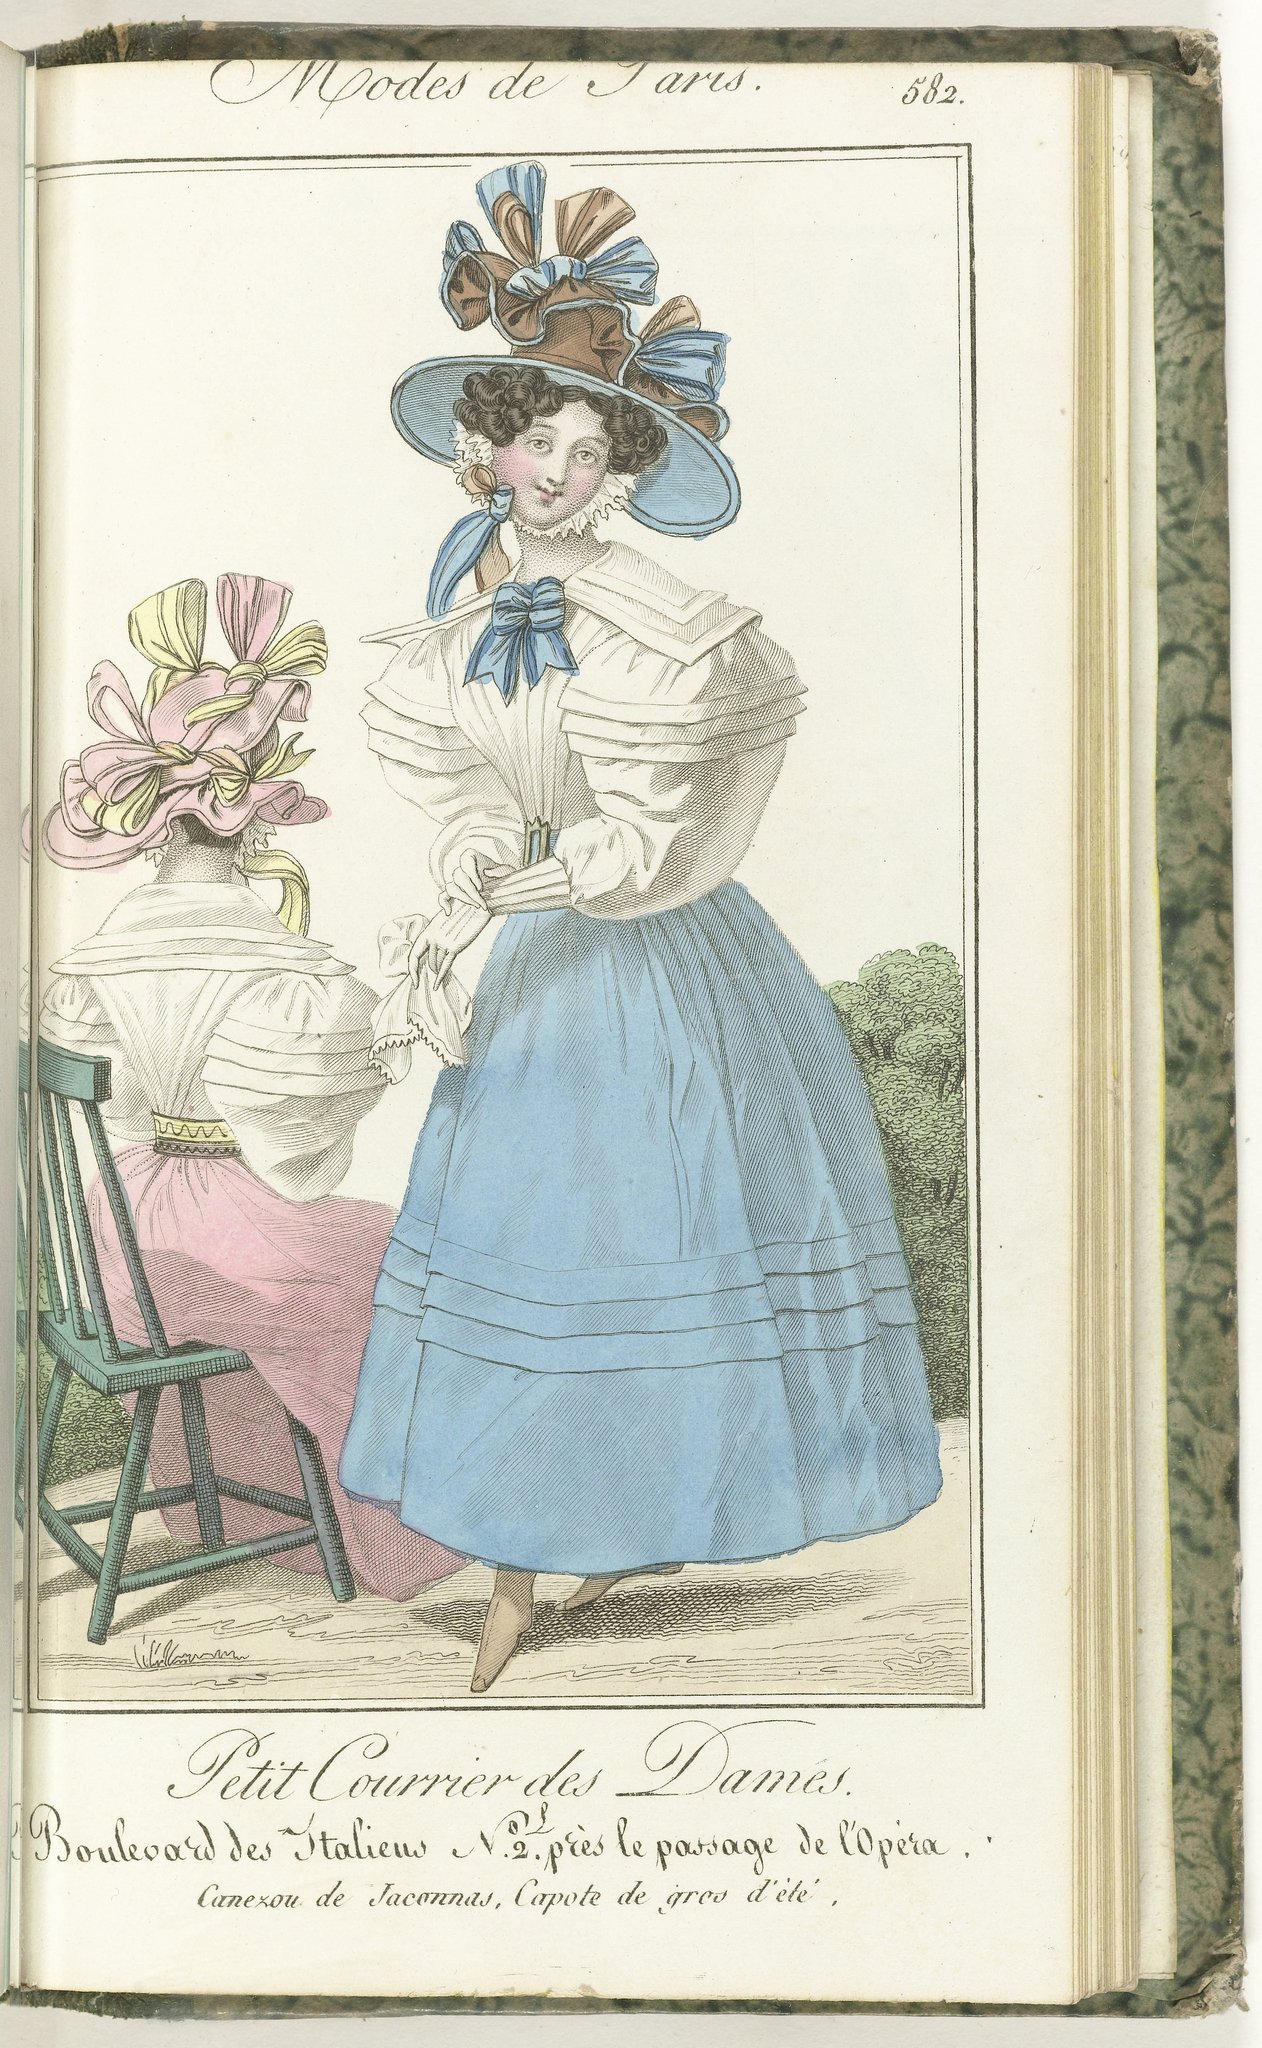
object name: fashion print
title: Petit Courrier des Dames, 15 septembre 1828,, No. 582 : Canezou de Jaconnas...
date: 1828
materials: paper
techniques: engraving, hand coloring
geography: paris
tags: handkerchief (+ women's clothes), head-gear (capote) (+ women's clothes), border, ribbon, braid (+ women's clothes), clothing for the upper part of the body: blouse (+ women's clothes), fashion plates, skirt (+ women's clothes)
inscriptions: caption: ‘Canezou de Jaconnas, Capote de gros d'été.’, address: ‘Boulevard des Italiens No.2 près le passage de l'Opèra.’, title: ‘Modes de Paris.’, title: ‘Petit Courrier des Dames.’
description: Staande figuur gekleed in een canezou van 'jaconas' op een wijd uitlopende rok. Op het hoofd een capote van 'gros d'été'. Zittende figuur in eenzelfde japon, op de rug gezien. Prent uit het modetijdschrift Petit Courrier des Dames (1821-1868). Ingebonden (met enkele pp. Le Journal des Dames et des Modes). 15 Januari 1827 t/m 20 maart 1830. Incompleet.